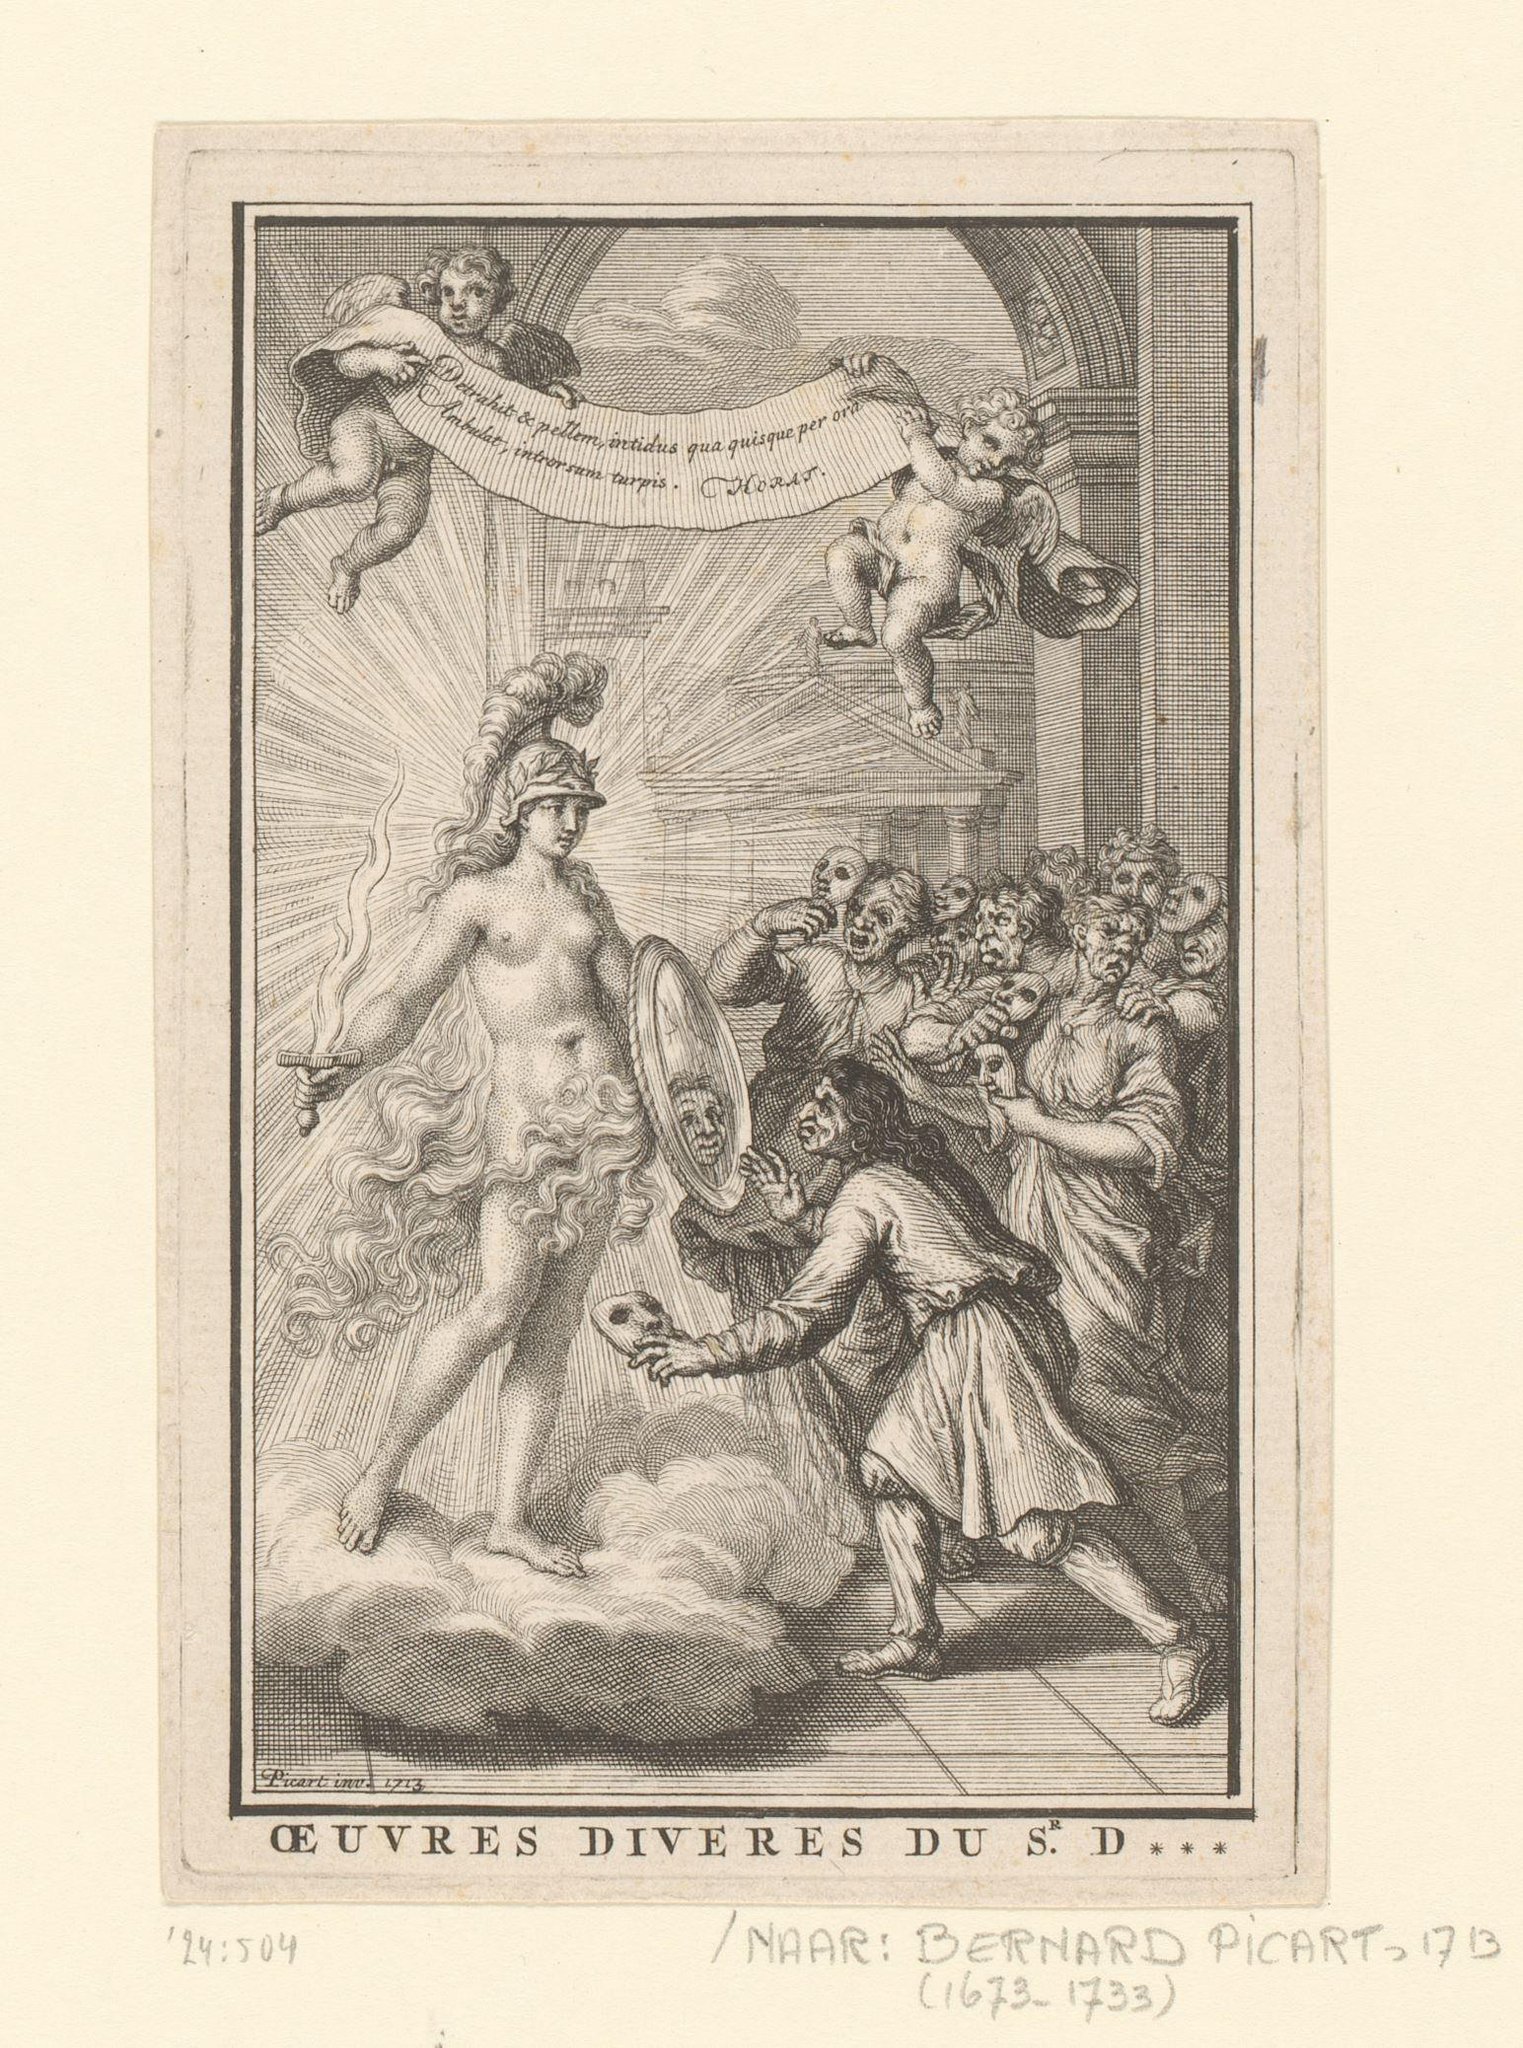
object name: book illustration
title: Allegorische voorstelling met Waarheid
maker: bernard picart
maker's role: draughtsman, print maker, publisher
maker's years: 1673-1733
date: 1713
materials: paper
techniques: etching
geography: amsterdam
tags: mask, truth; 'verità' (ripa), reflection (in a mirror)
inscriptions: collector's mark: Lugt 2233, stamp: ‘ICON’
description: De personificatie van waarheid, een vrouw met een vlammend zwaard in de hand, houdt een aantal toneelspelers met maskers in de hand een spiegel voor. In de lucht twee putti met een banderol waarop het portret van Horatius. In de marge een tweeregelig onderschrift in het Latijn.